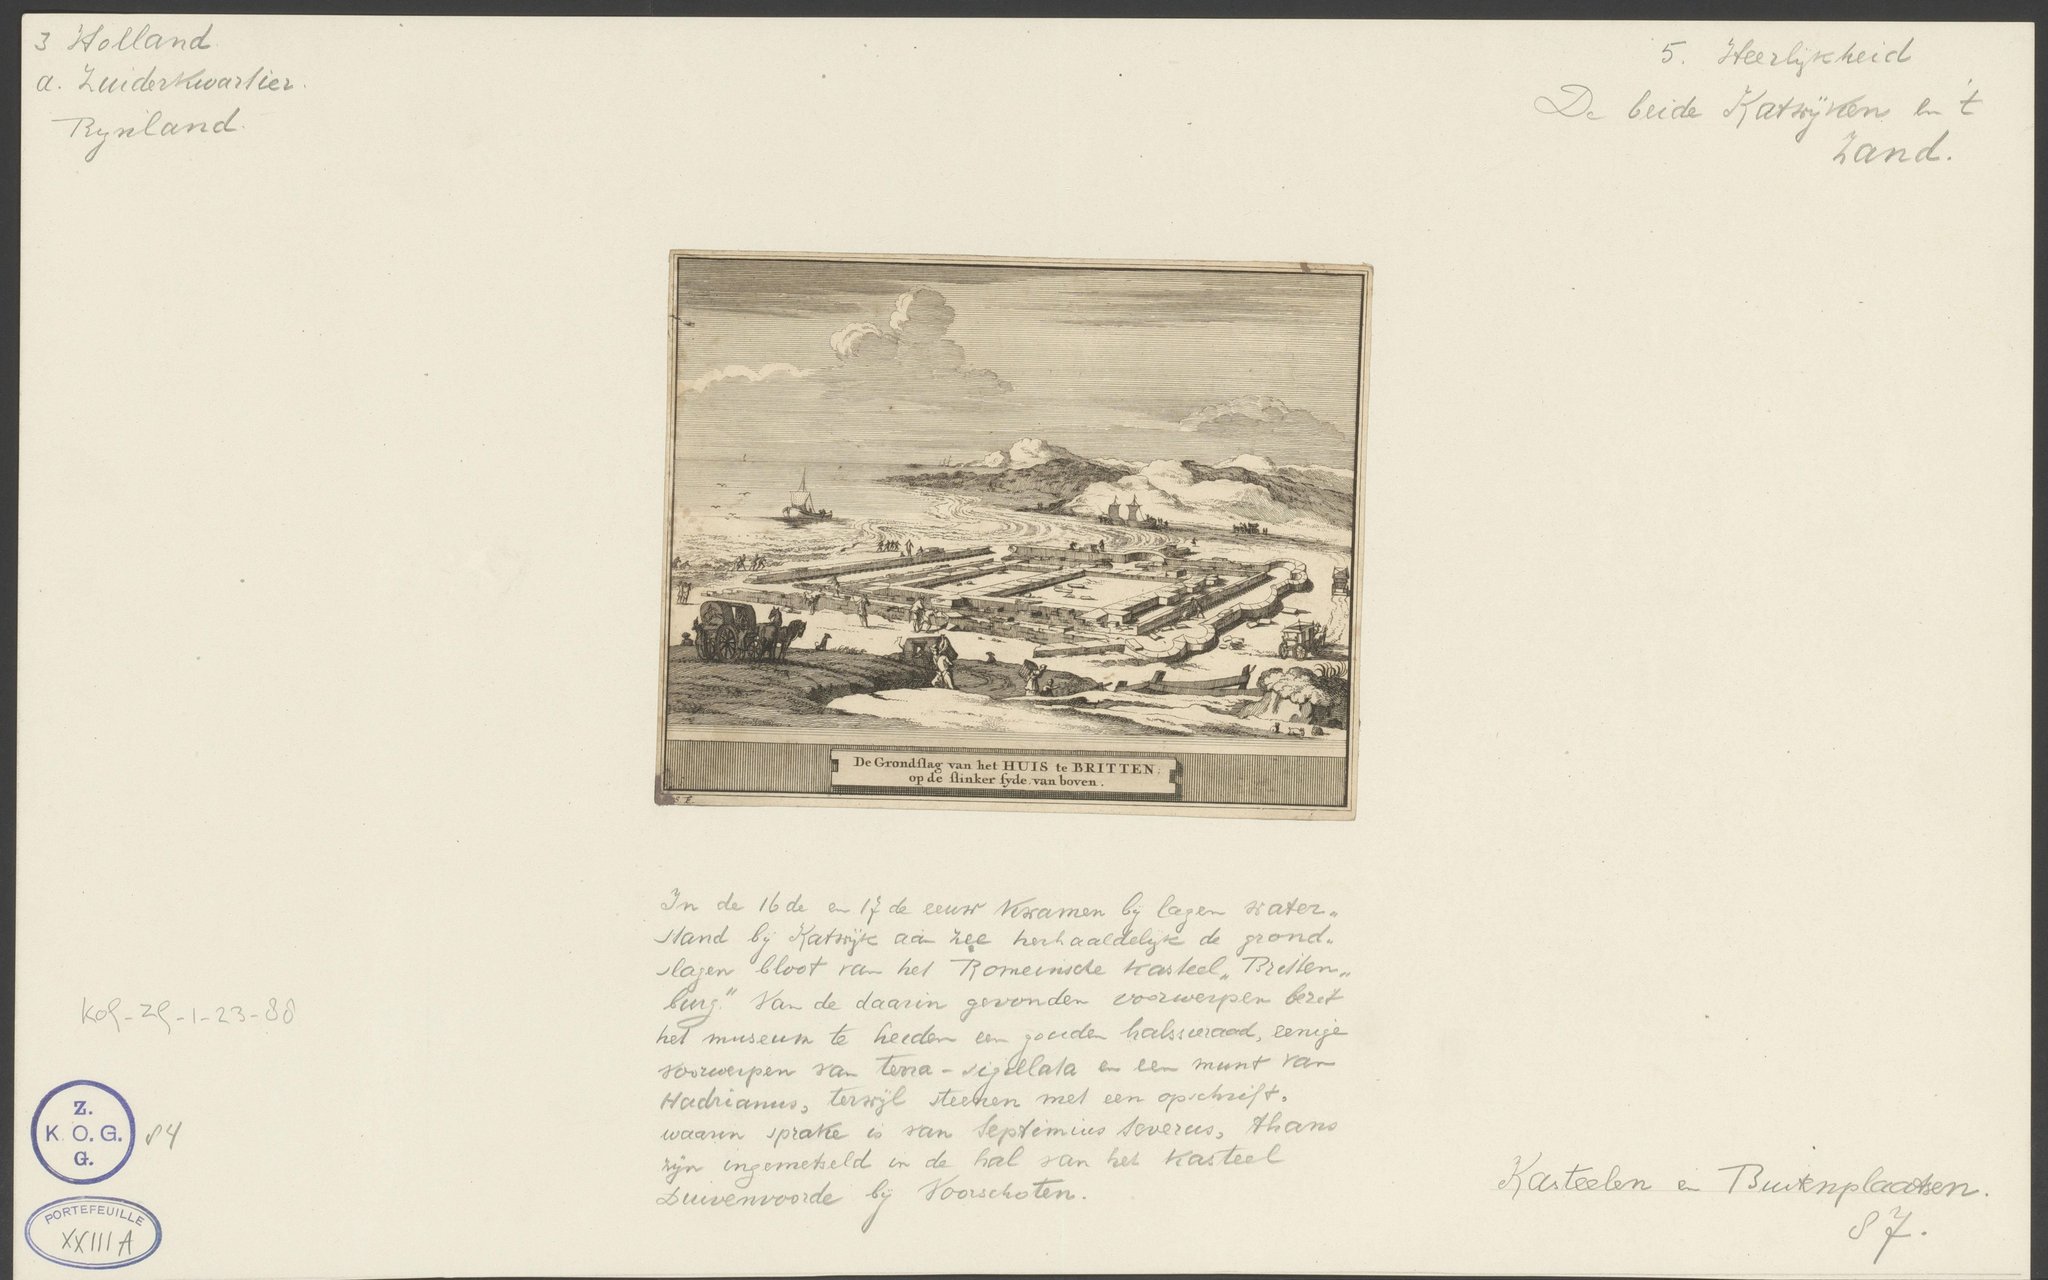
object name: print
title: Gezicht op de opgraving van Huis te Britten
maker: jacobus schijnvoet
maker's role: draughtsman, print maker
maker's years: 1685-1743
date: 1711-1774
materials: paper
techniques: etching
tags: ruin of a dwelling, house, castle, etc., sea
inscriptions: stamp, collector's mark: Lugt 1641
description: Prent mogelijk uit: Smids, Ludolph. Schatkamer der Nederlandsse[!] oudheden; of Woordenboek, behelsende Nederlands steden, Amsterdam: Pieter de Coup, 1711. Verscheen tevens in de heruitgave van voorgenoemd werk in 1737 en 1774. In 1721 verscheen er een uitgave met alleen de prenten: Nederlandsche oudheden, bestaande in zestig verbeeldingen (...) gelegen in Holland, 't Sticht van Utrecht en Gelderland enz. Amsterdam: Hendrik Bosch, 1721.